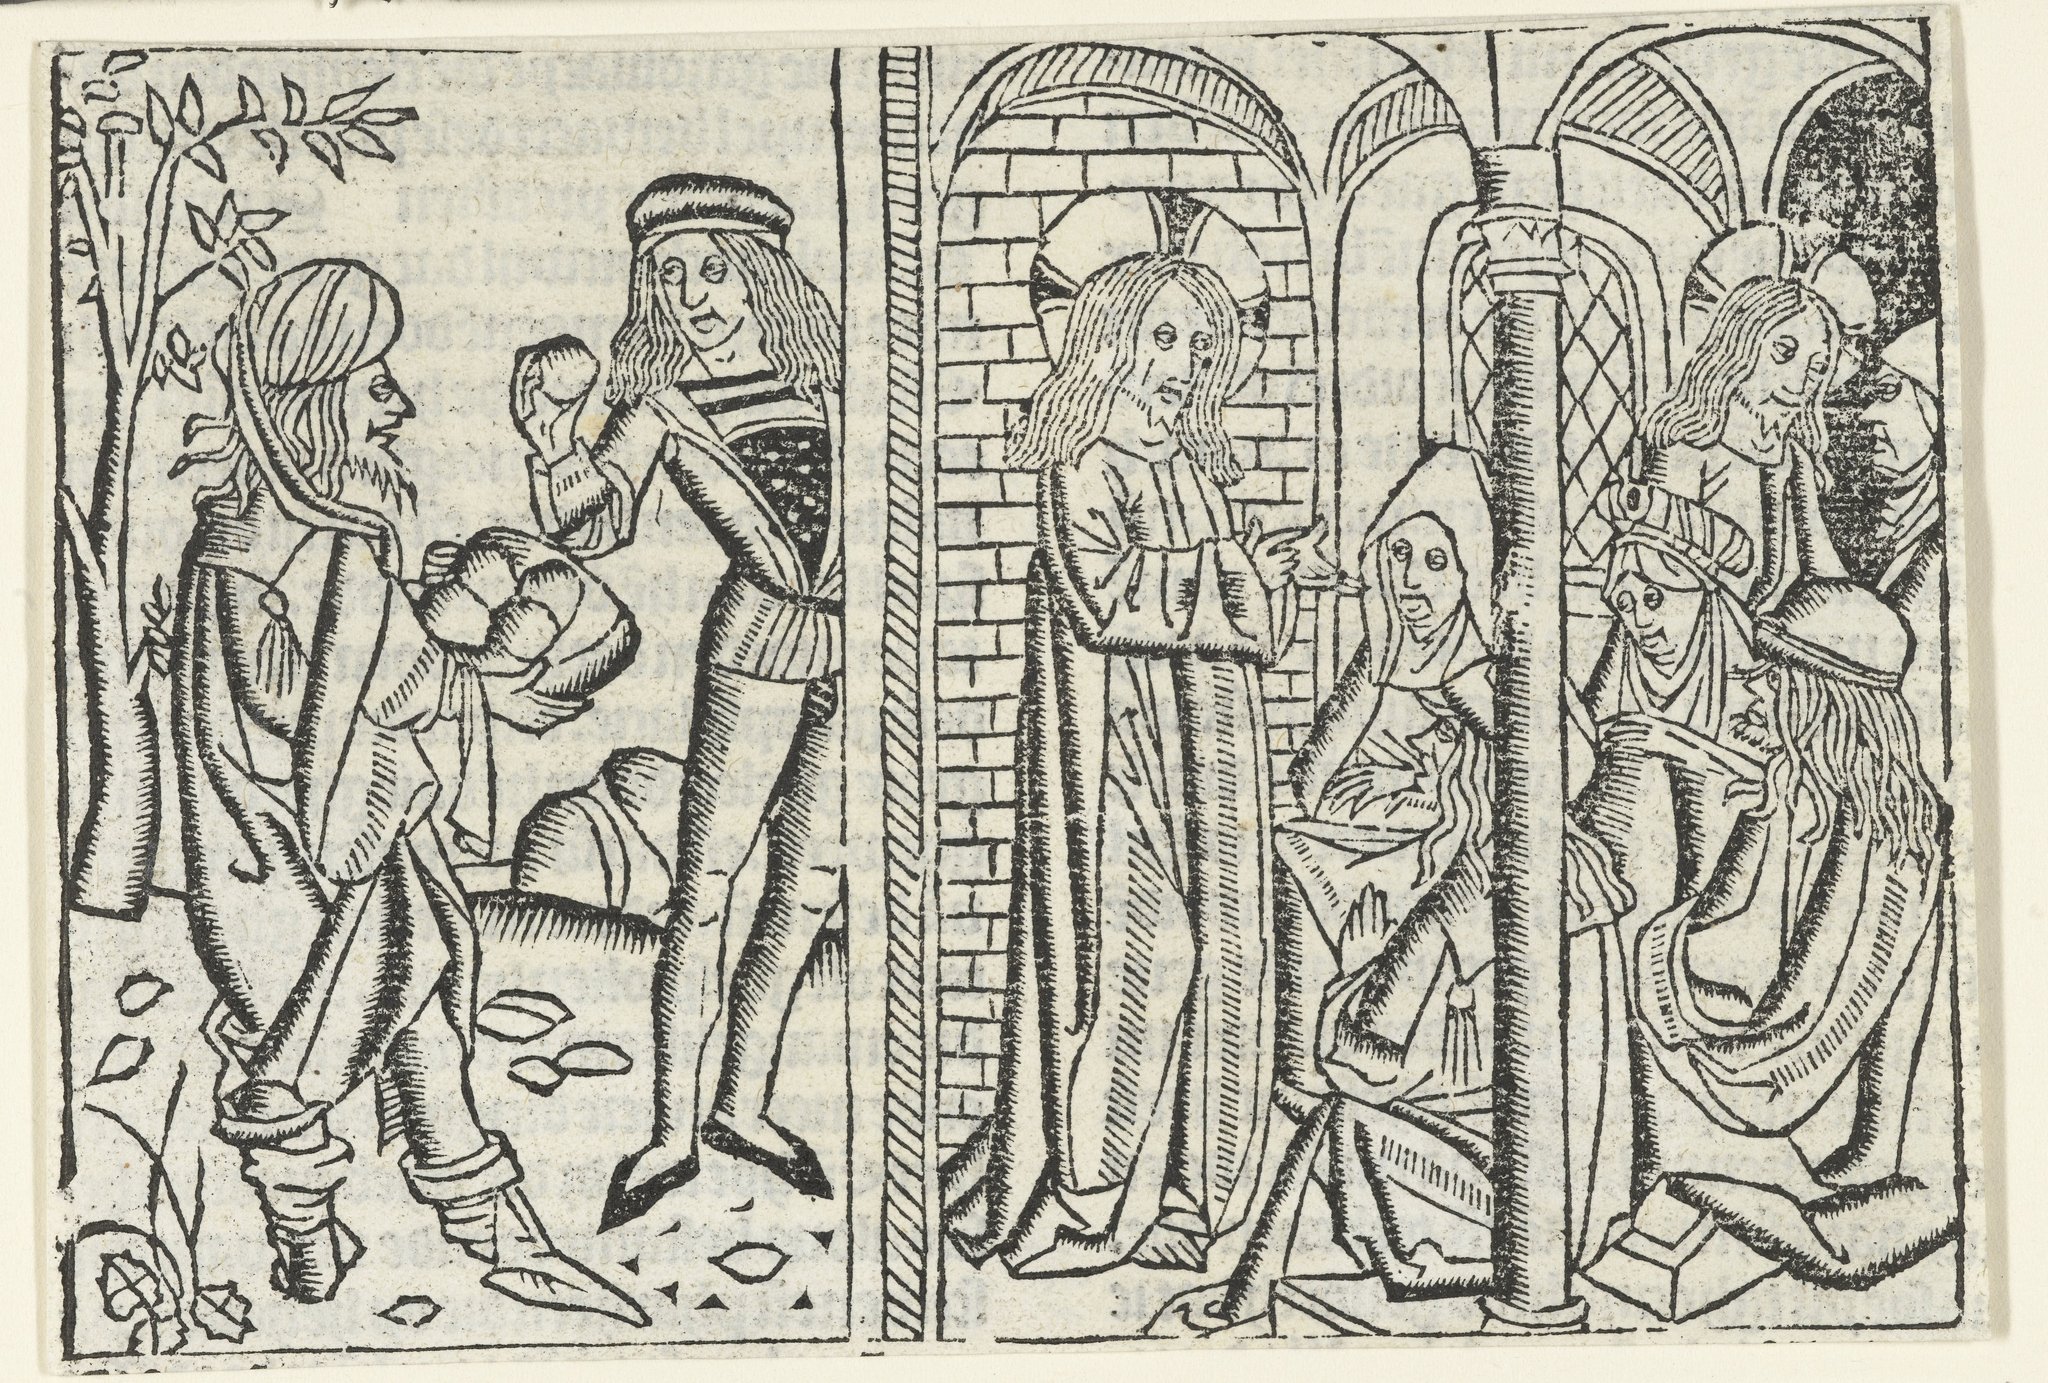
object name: book illustration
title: De Farizeeërs willen Christus stenigen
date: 1480-1500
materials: paper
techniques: woodcut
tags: attempts to stone christ (john 8:59, 10:31-33)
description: Eén blad van 113 uit Ludolphus de Saxonia, "Dit es dleué ons liefs heeren ihesu christi". Anonieme Nederlandse vertaling. Uitgegeven door Henrick Eckert van Homberch te Antwerpen in 1503. Botke, K. Deze 113 houtsneden, die meestal reeds in vroege Nederlandse boeken gebruikt zijn, worden toegeschreven aan de tweede Meester van Delft, de Meester van de Delbecq-Schreiber-passie en de Meester van de Virgo inter Virgines. In Conway (1884) en in "De gulden passer"(1951) zijn ook eerdere versies opgenomen. Botke, K.